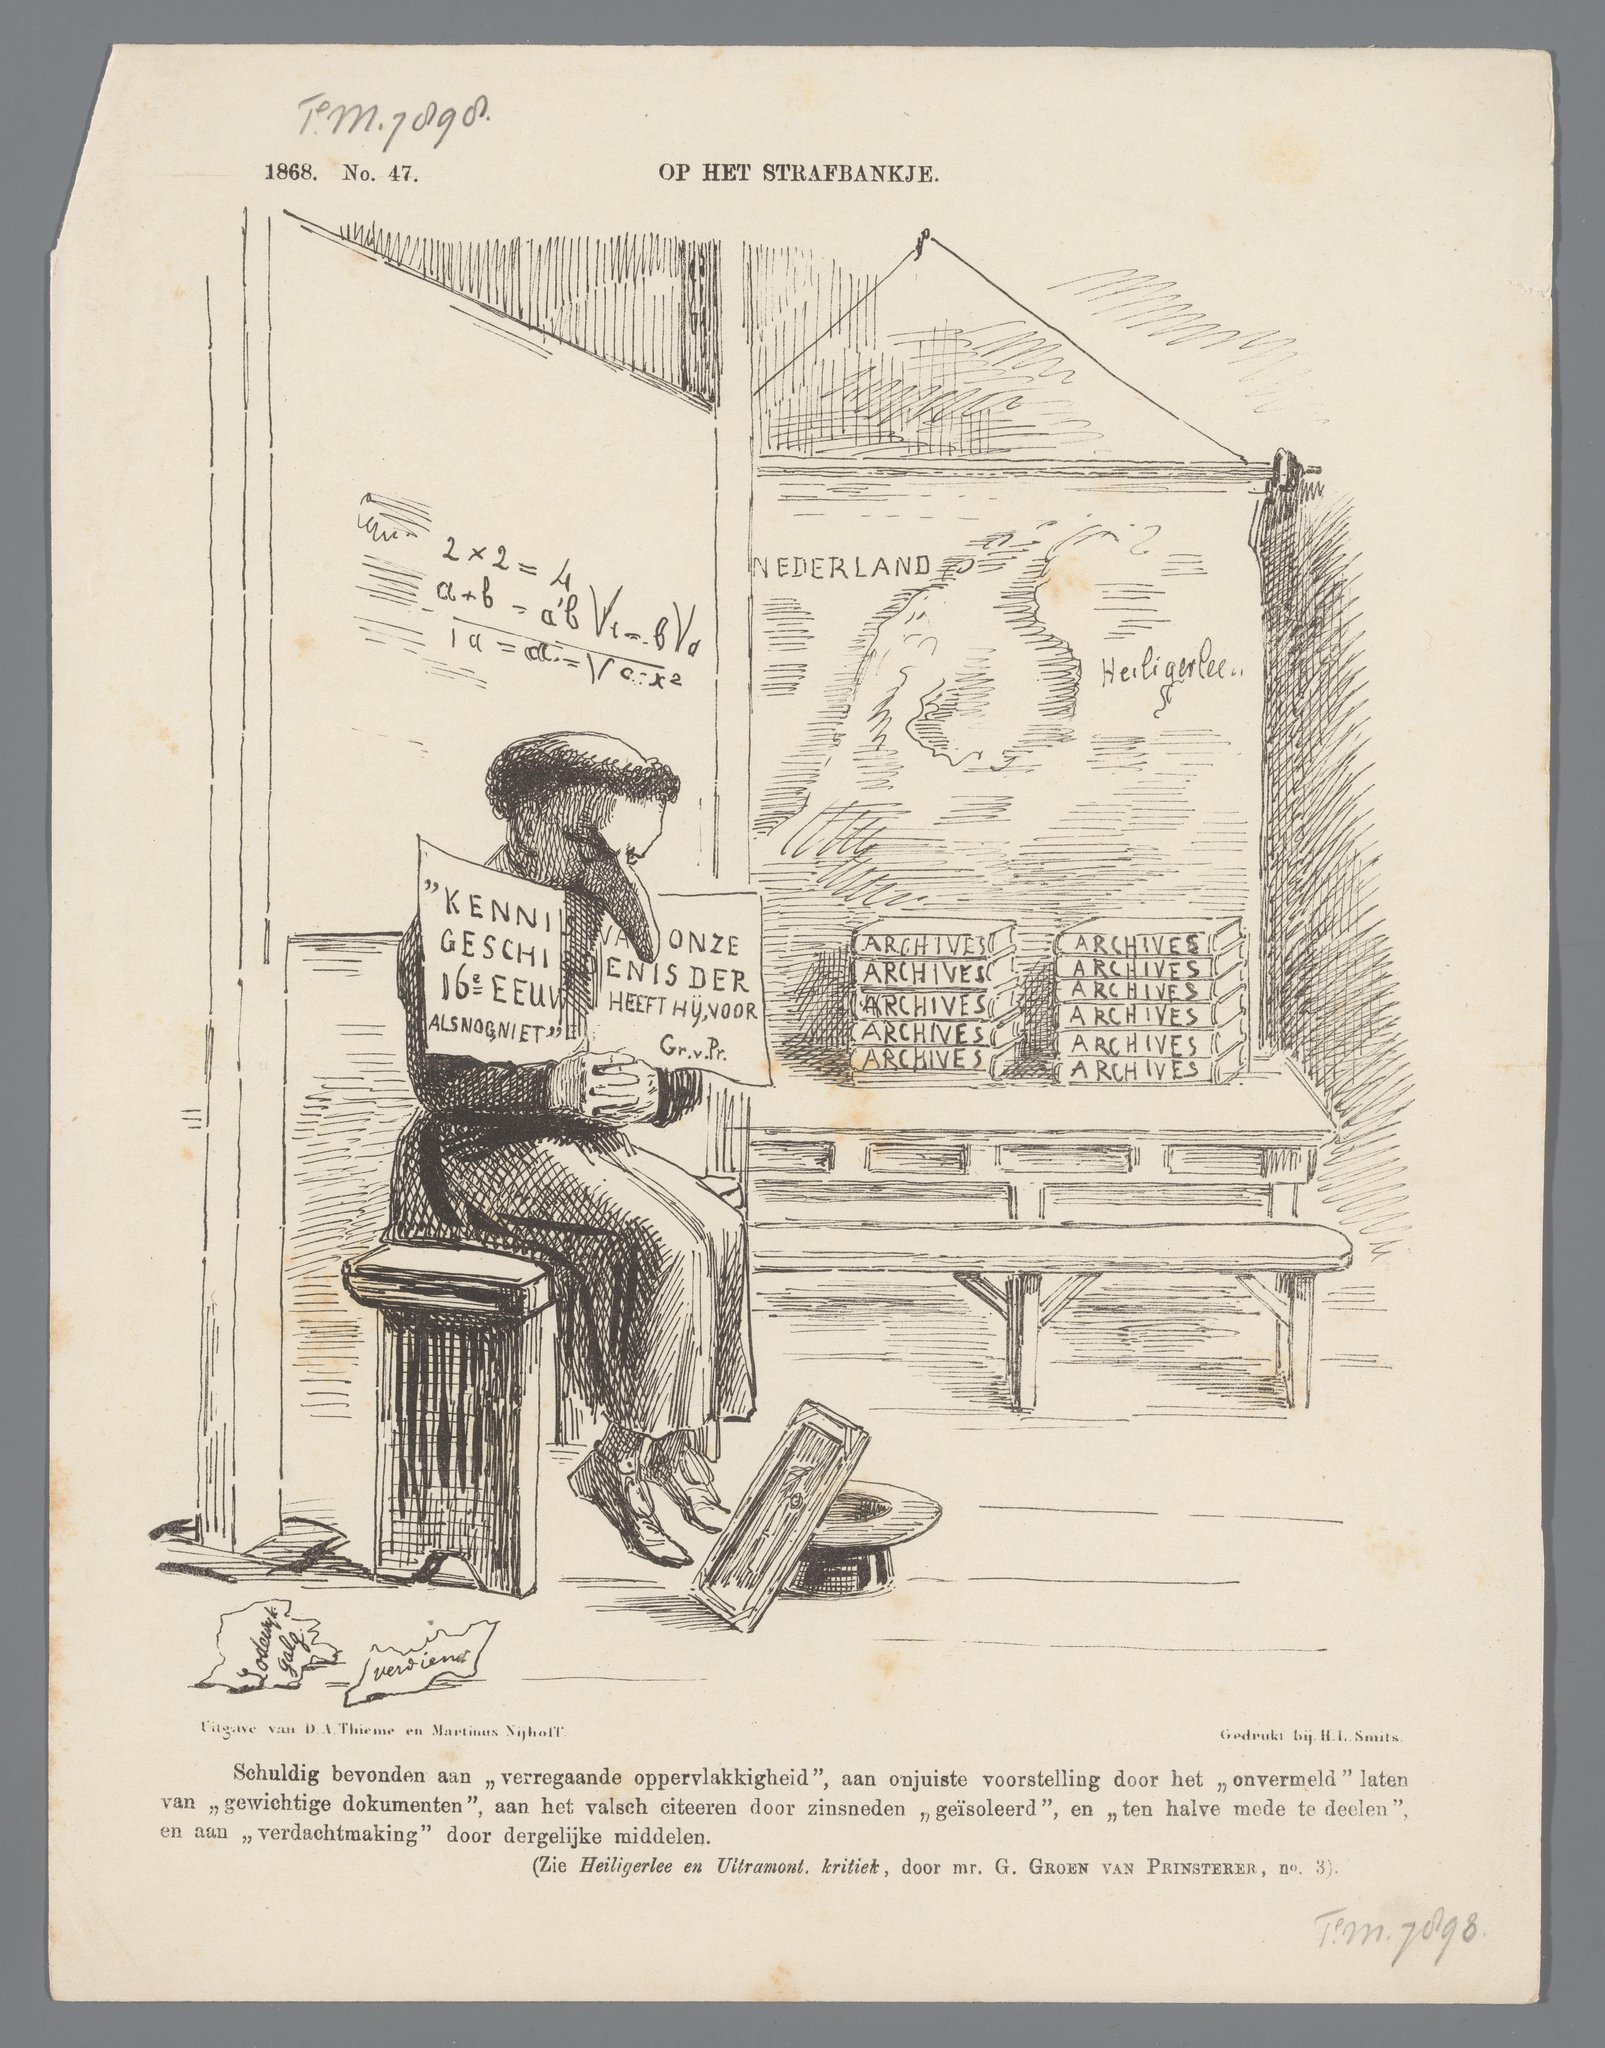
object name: cartoon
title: Op het strafbankje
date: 1867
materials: paper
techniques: lithograph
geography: arnhem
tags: guillaume groen van prinsterer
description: Spotprent op abt Brouwers nav Groen van Prinsterers kritiek op van diens geschrift over de viering van de Slag bij Heiligerlee. Plaat verschenen bij het weekblad De Nederlandsche Spectator, nr. 47, 21 november 1868.